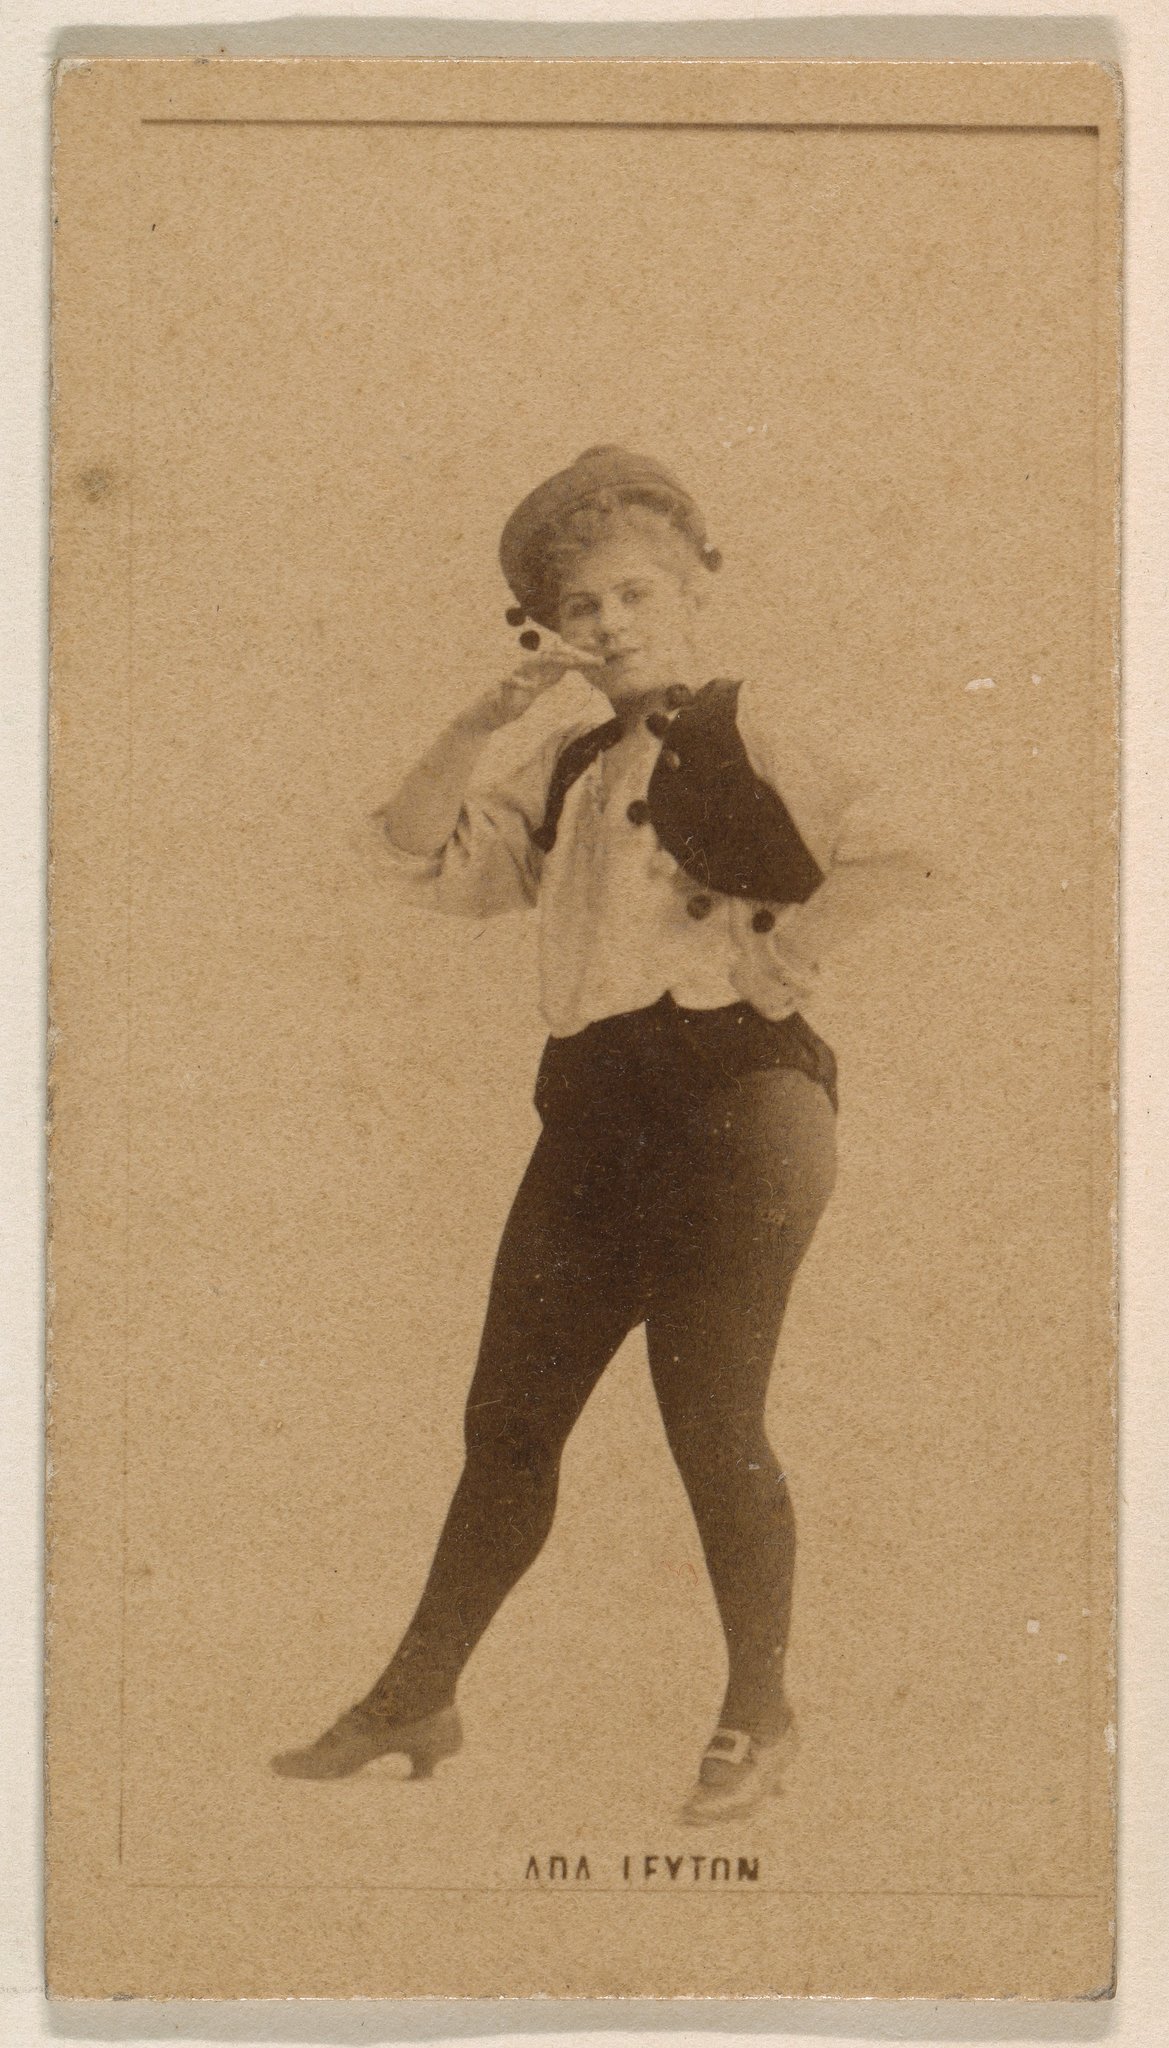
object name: photograph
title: Ada Leyton, from the Actresses series (N245) issued by Kinney Brothers to promote Sweet Caporal Cigarettes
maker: kinney brothers tobacco company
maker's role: publisher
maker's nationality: american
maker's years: 1869-2011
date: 1890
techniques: albumen silver print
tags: portraits,women,actresses